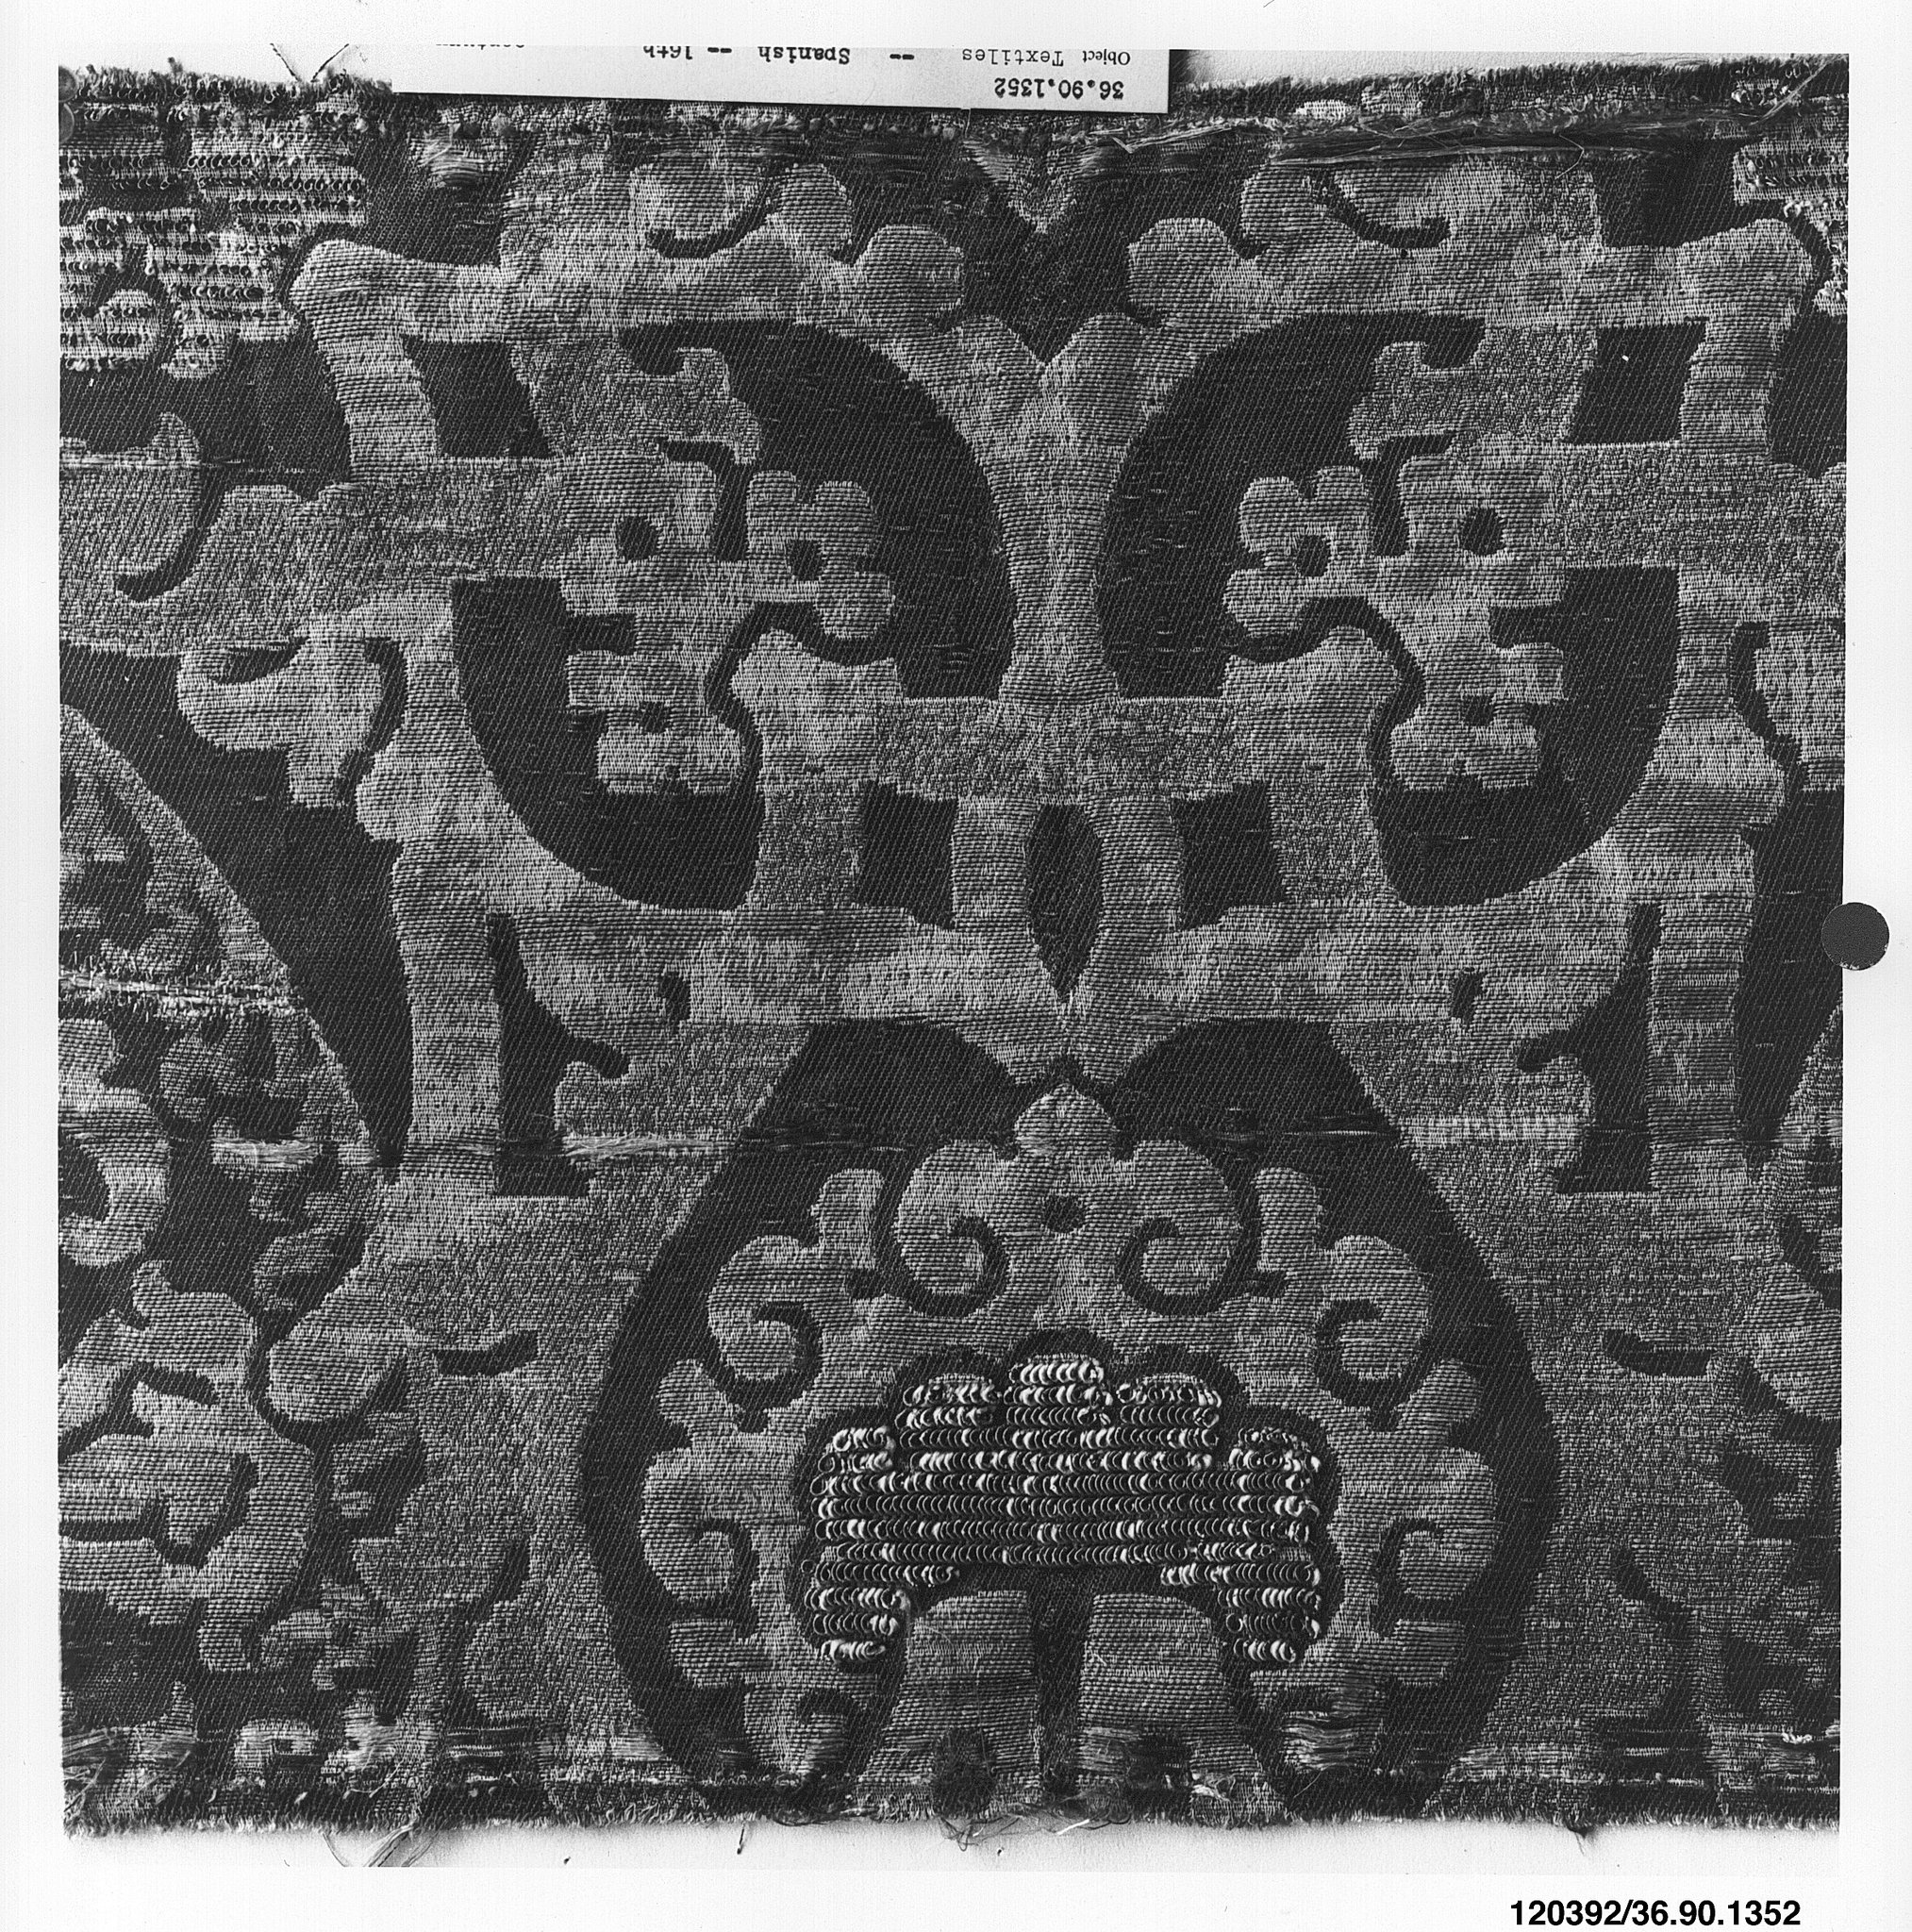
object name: piece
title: Pieces (2)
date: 1501-1600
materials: hemp, metal thread, silk